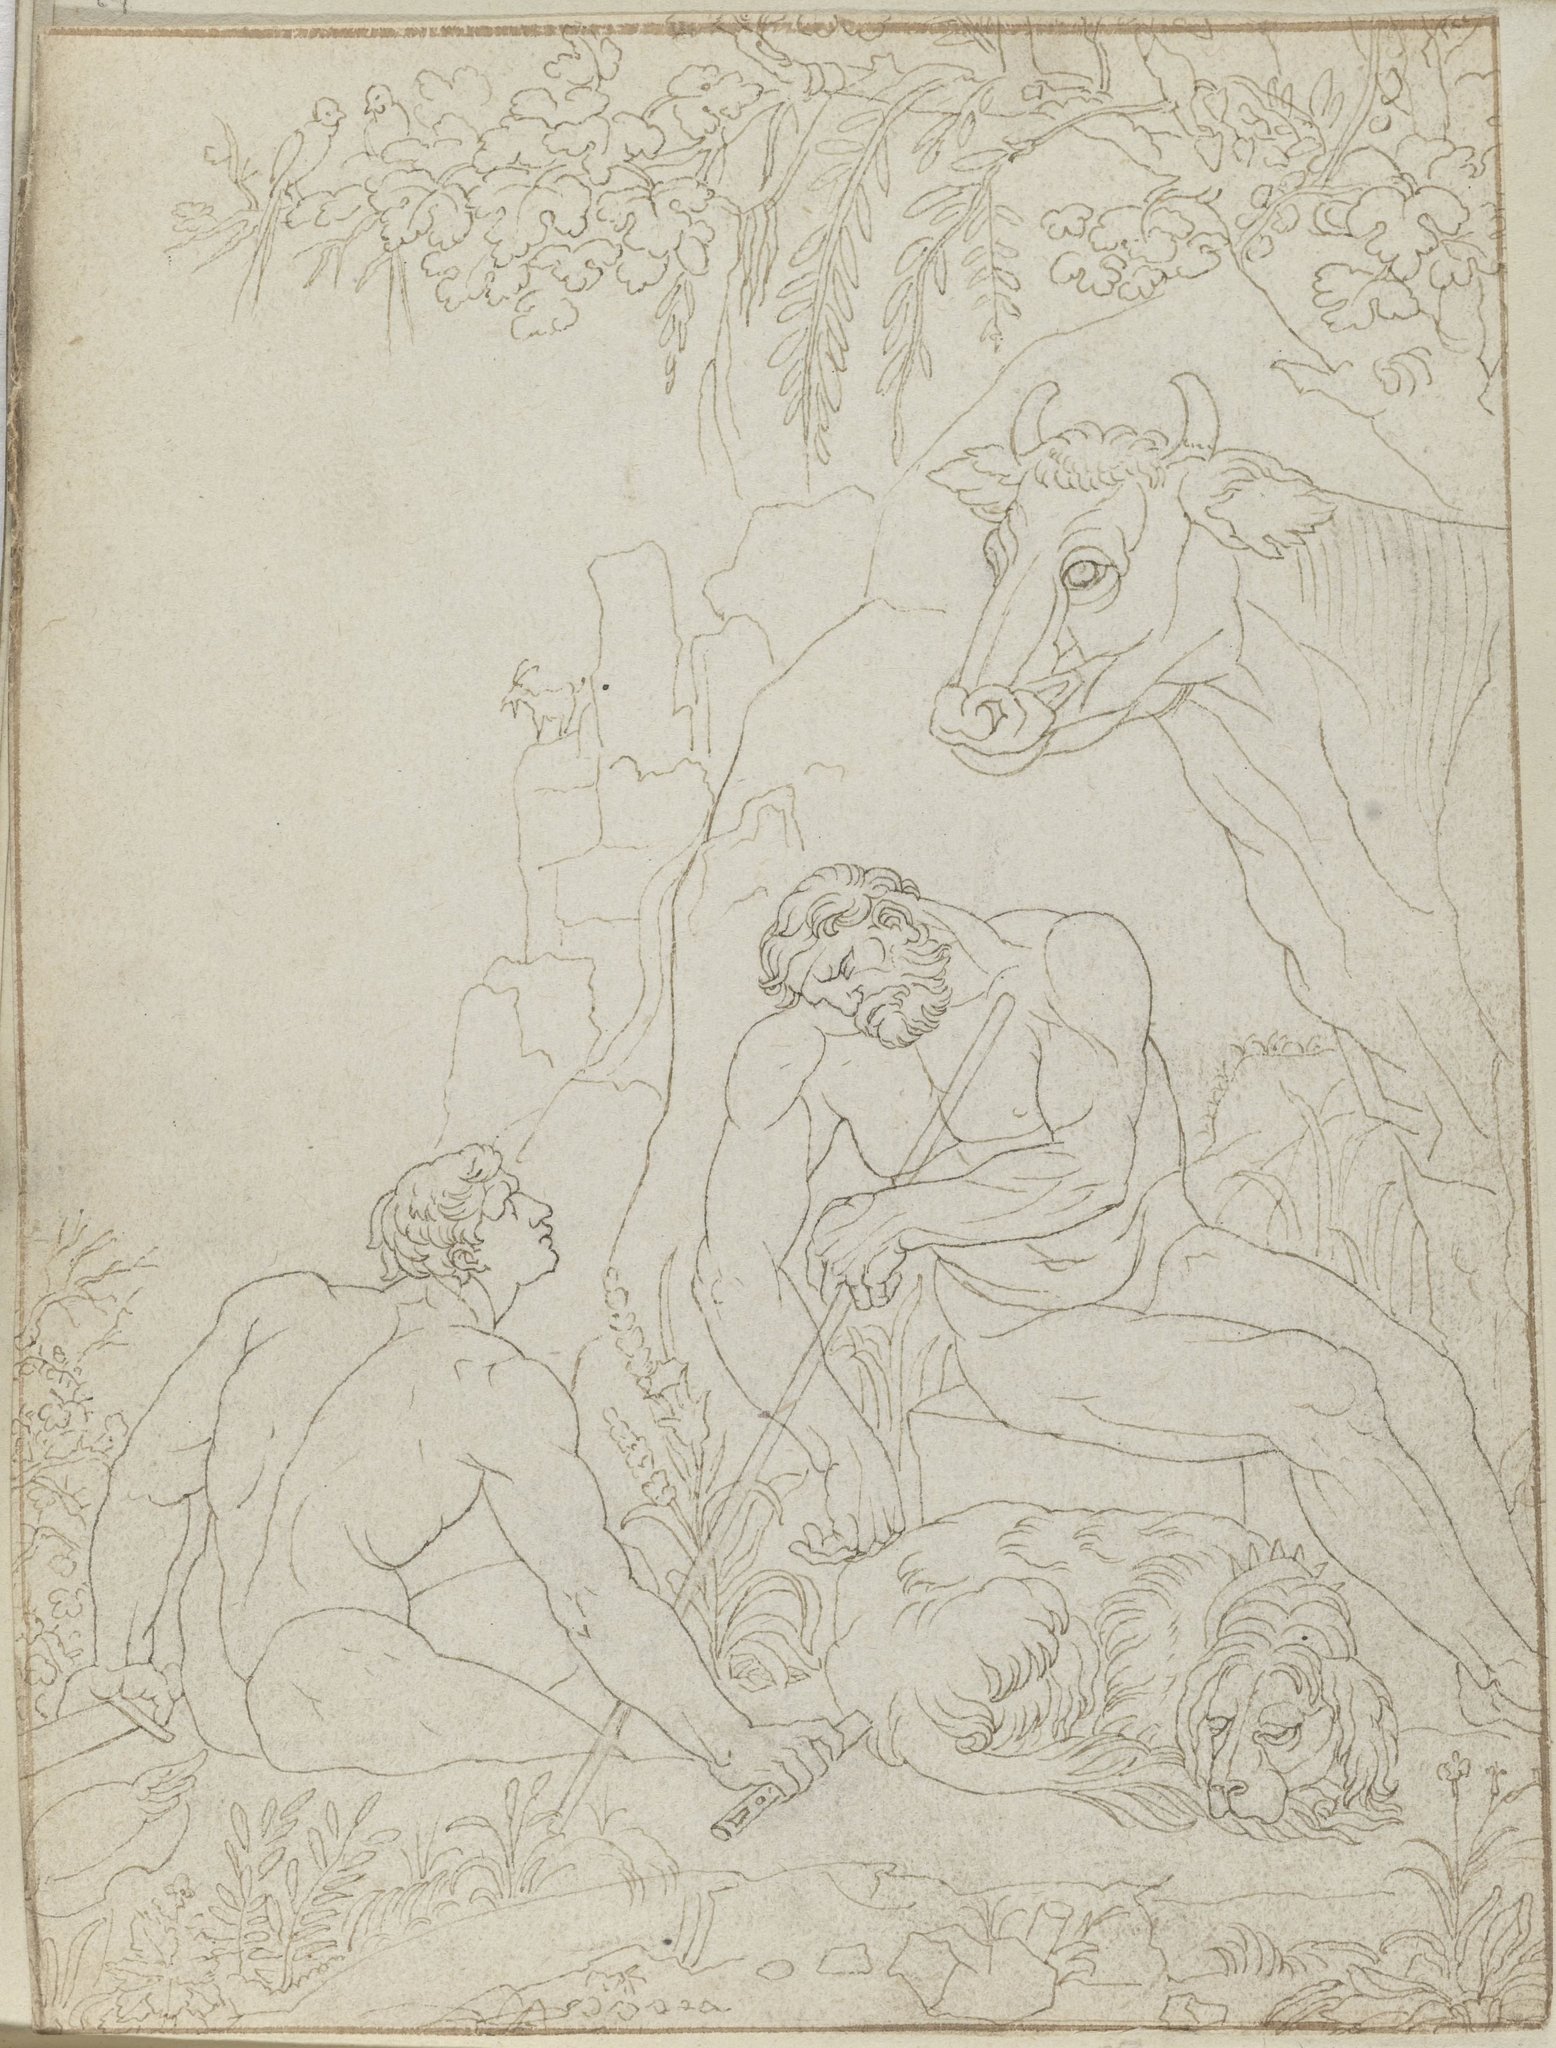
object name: drawing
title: Twee naakte mannen en een stier en een liggende leeuw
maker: Anonymous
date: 1700-1799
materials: ink, paper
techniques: pen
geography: netherlands